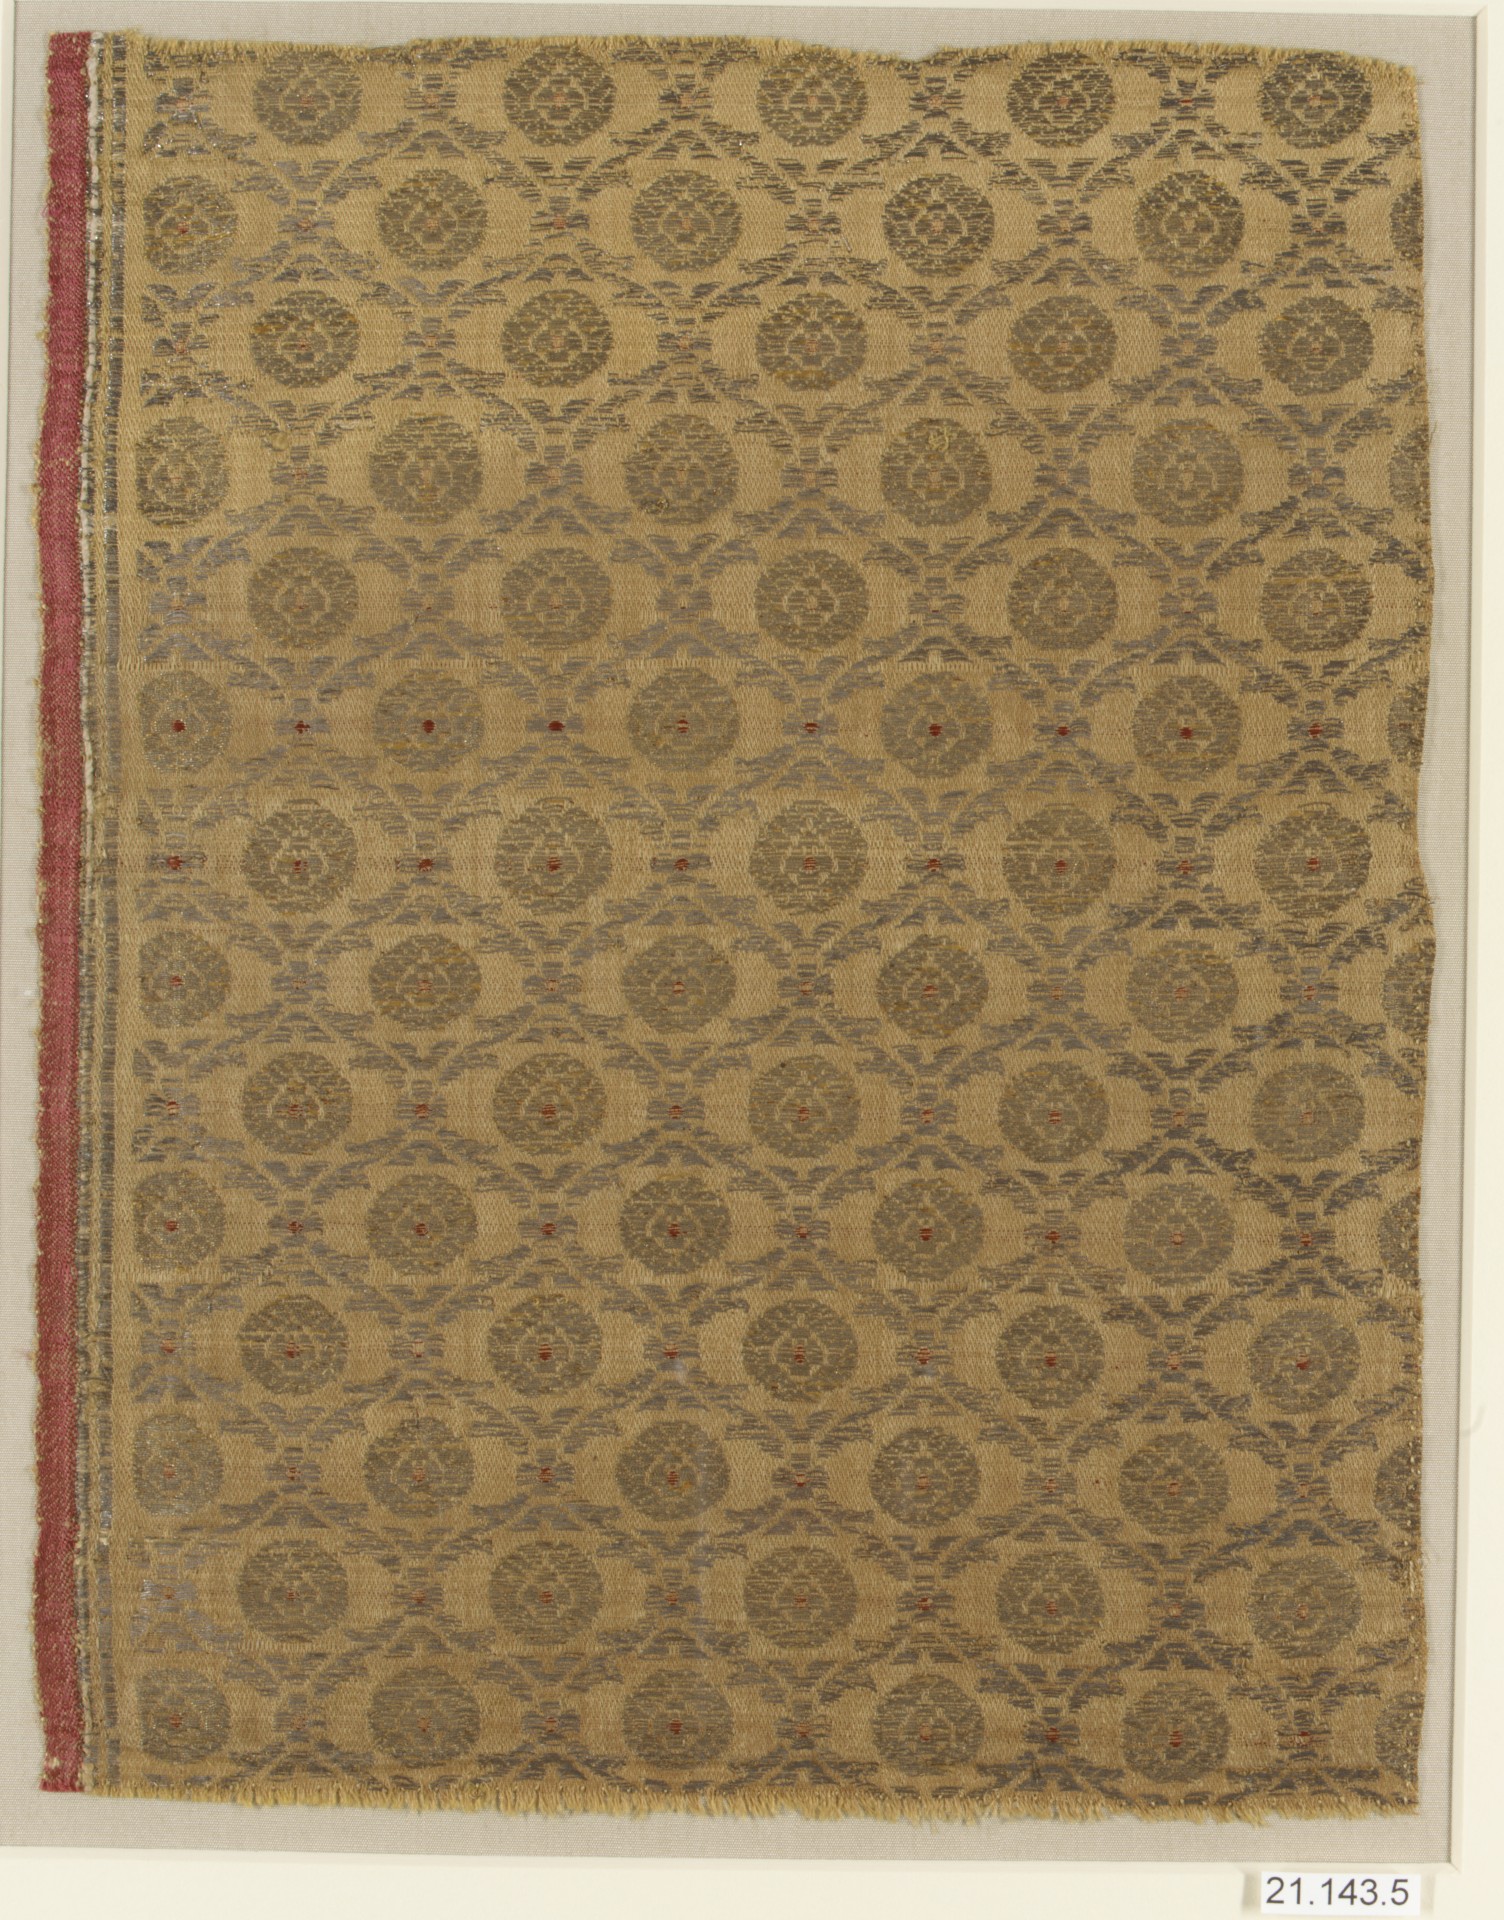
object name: brocade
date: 1801-1900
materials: cotton, metal thread, silk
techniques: brocade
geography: india